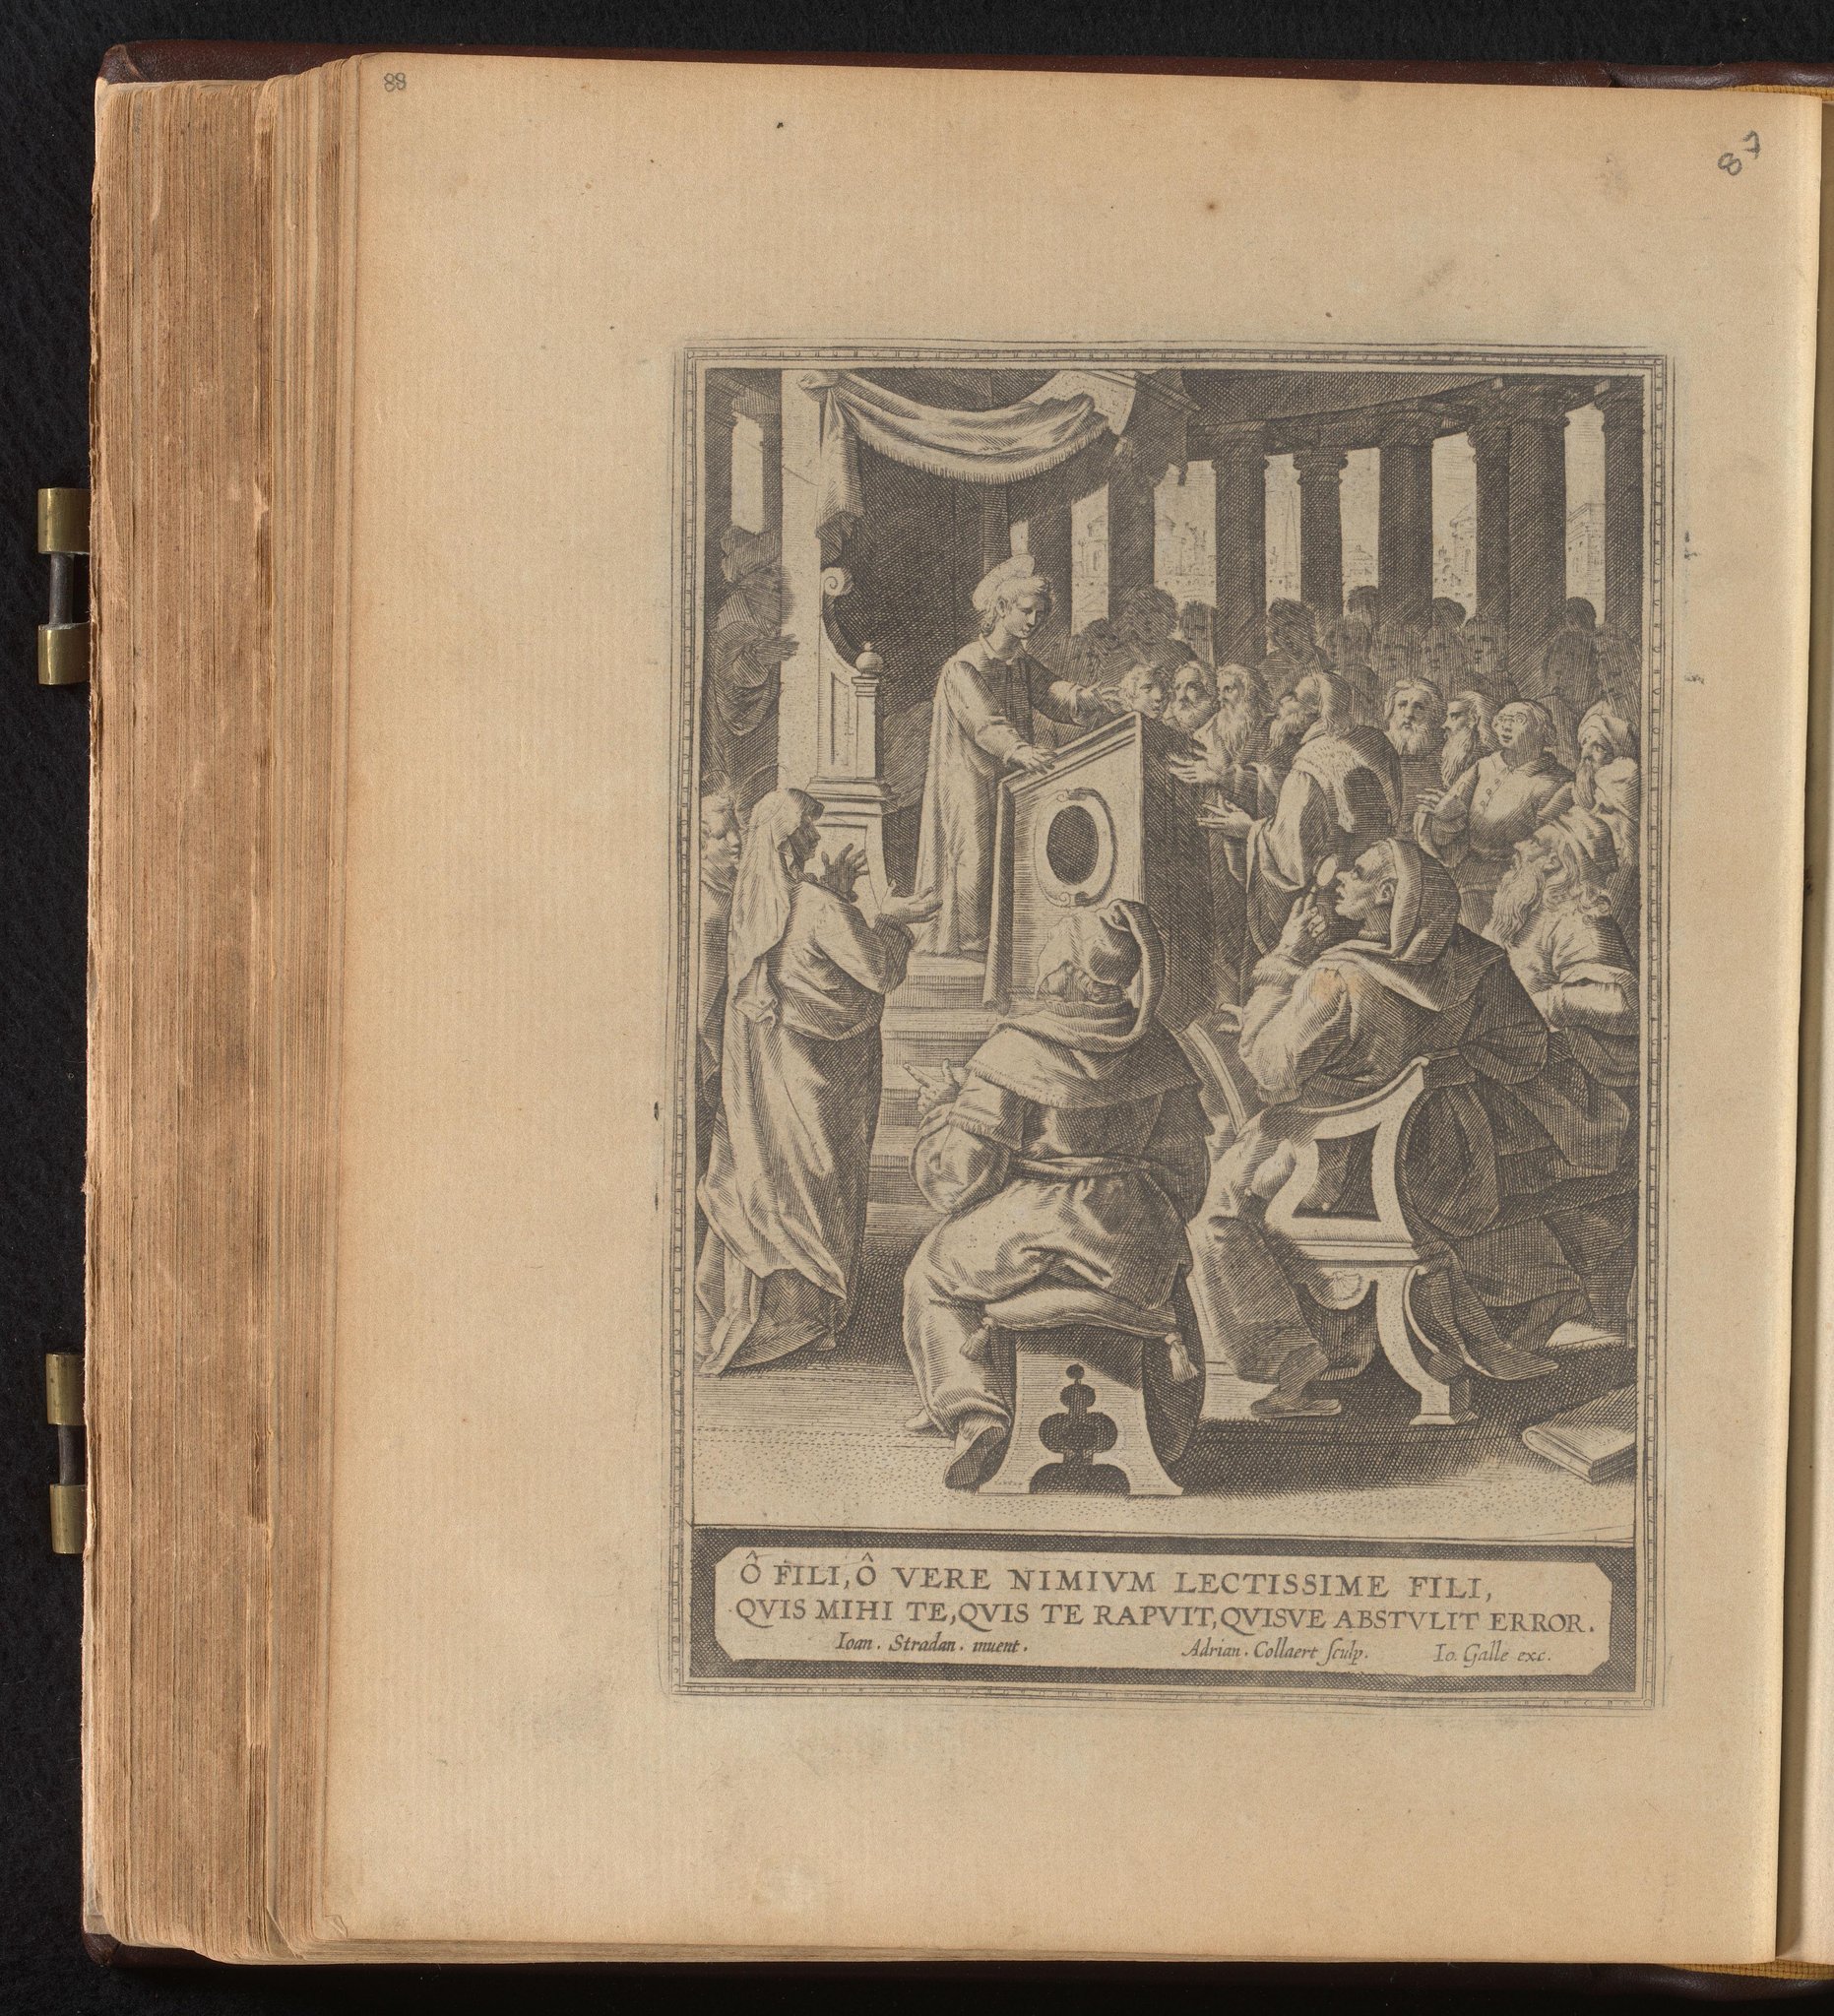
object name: print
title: Twaalfjarige Christus in de tempel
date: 1589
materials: paper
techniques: engraving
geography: antwerp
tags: christ's dispute with the doctors in the temple; he counts his arguments on his fingers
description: Prent maakt deel uit van een prentbijbel.